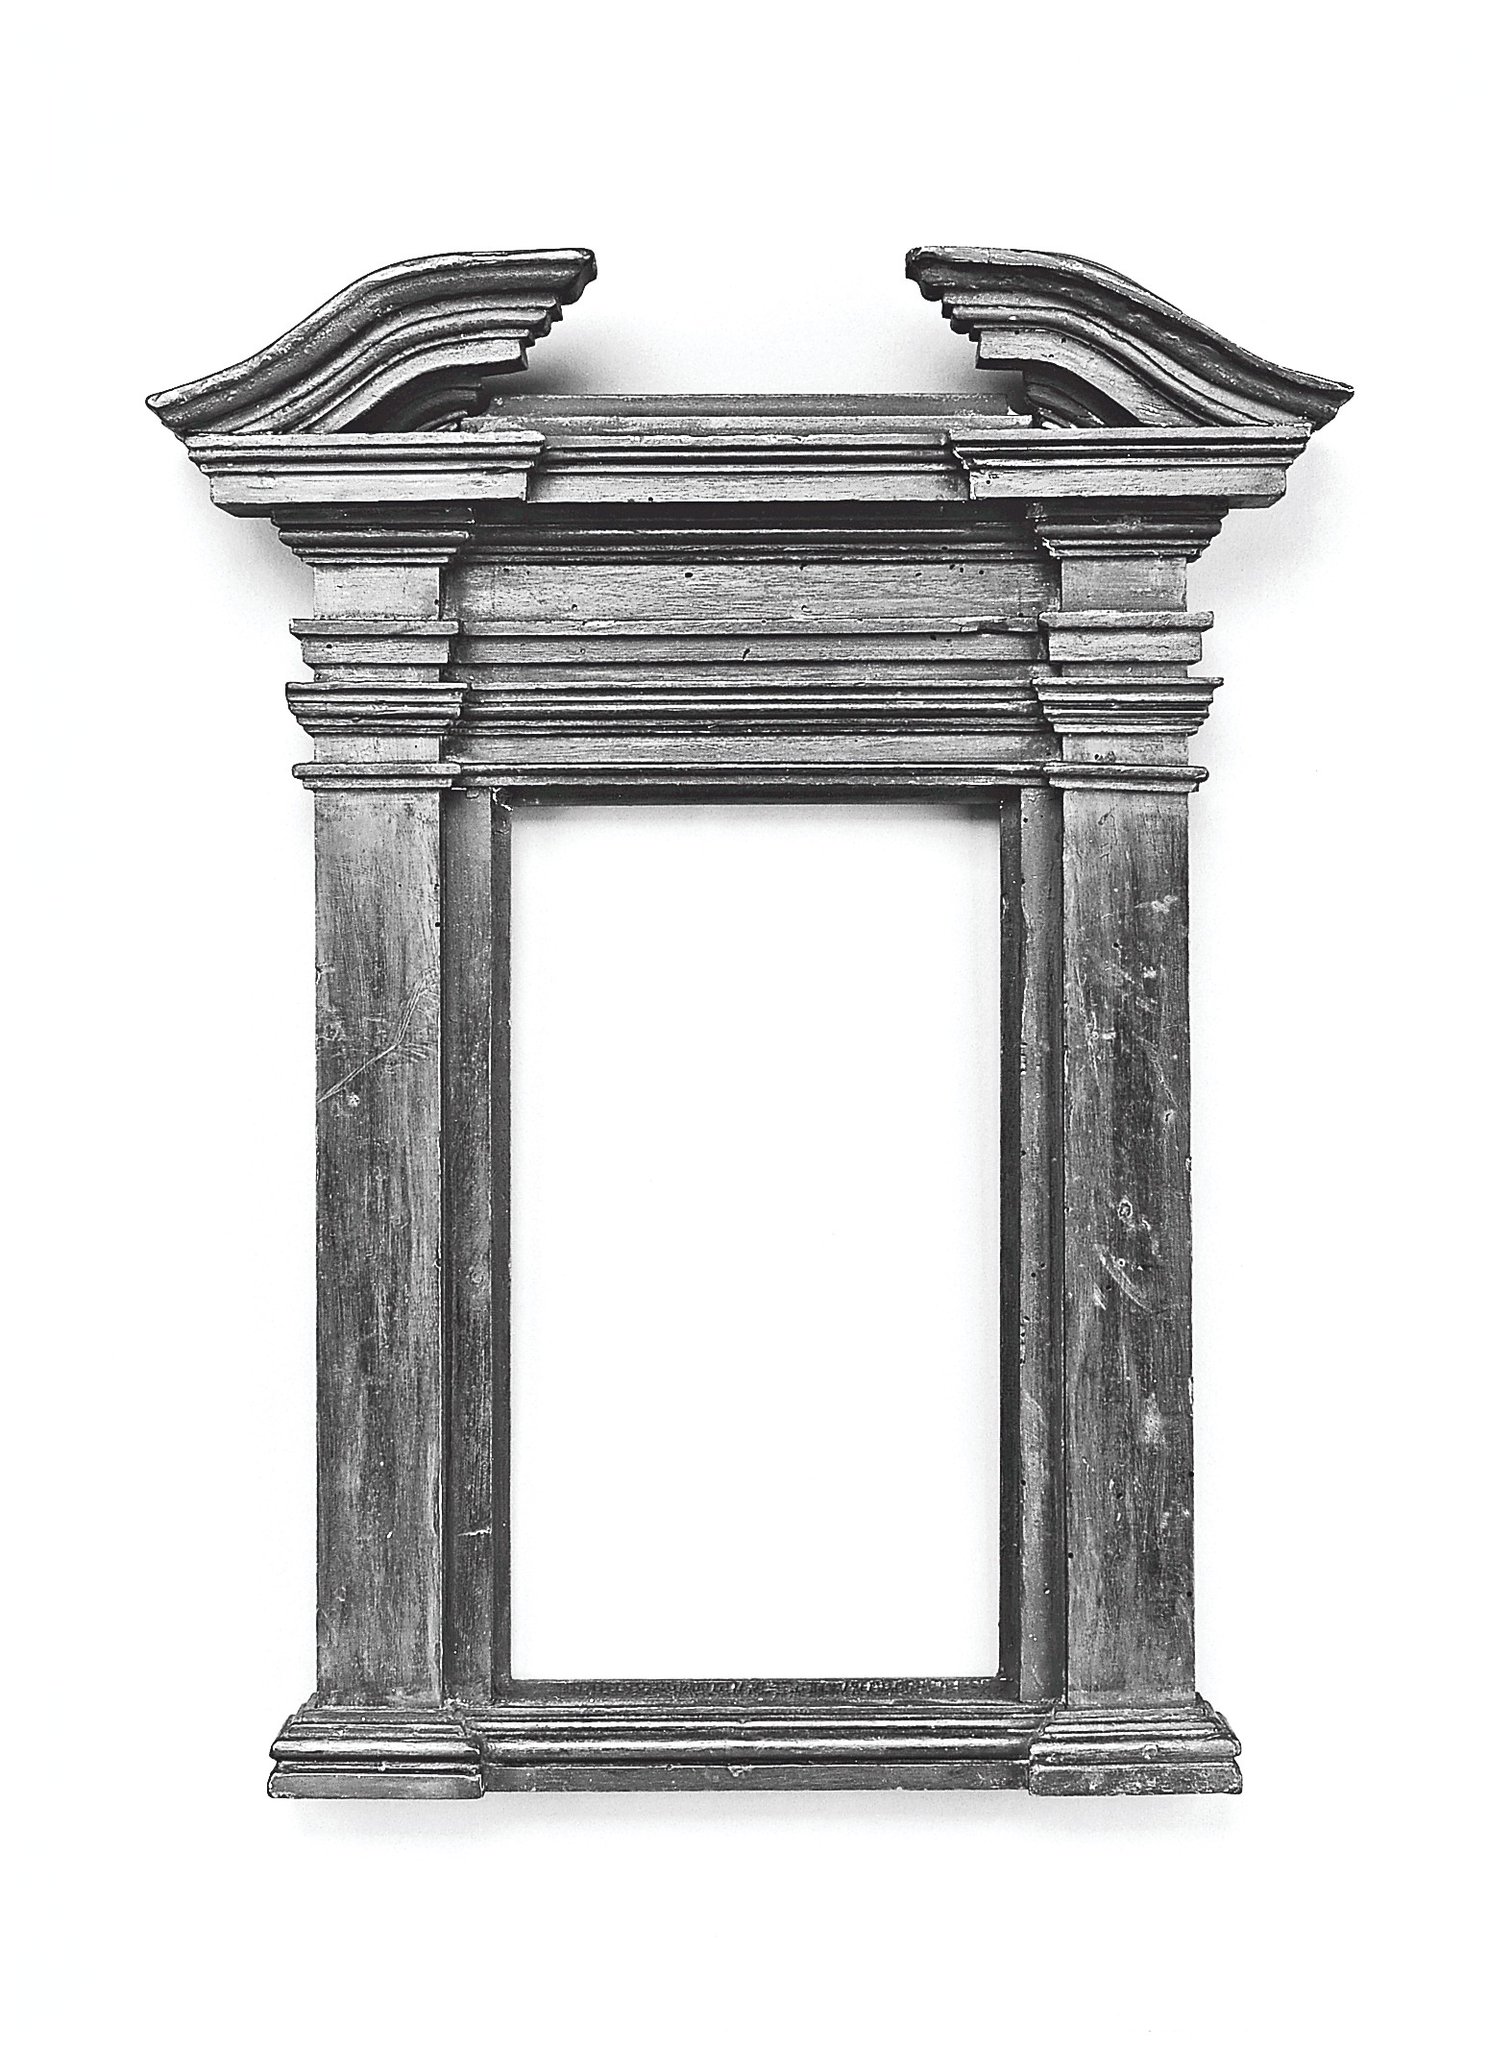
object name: frame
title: Tabernacle frame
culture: italian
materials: wood